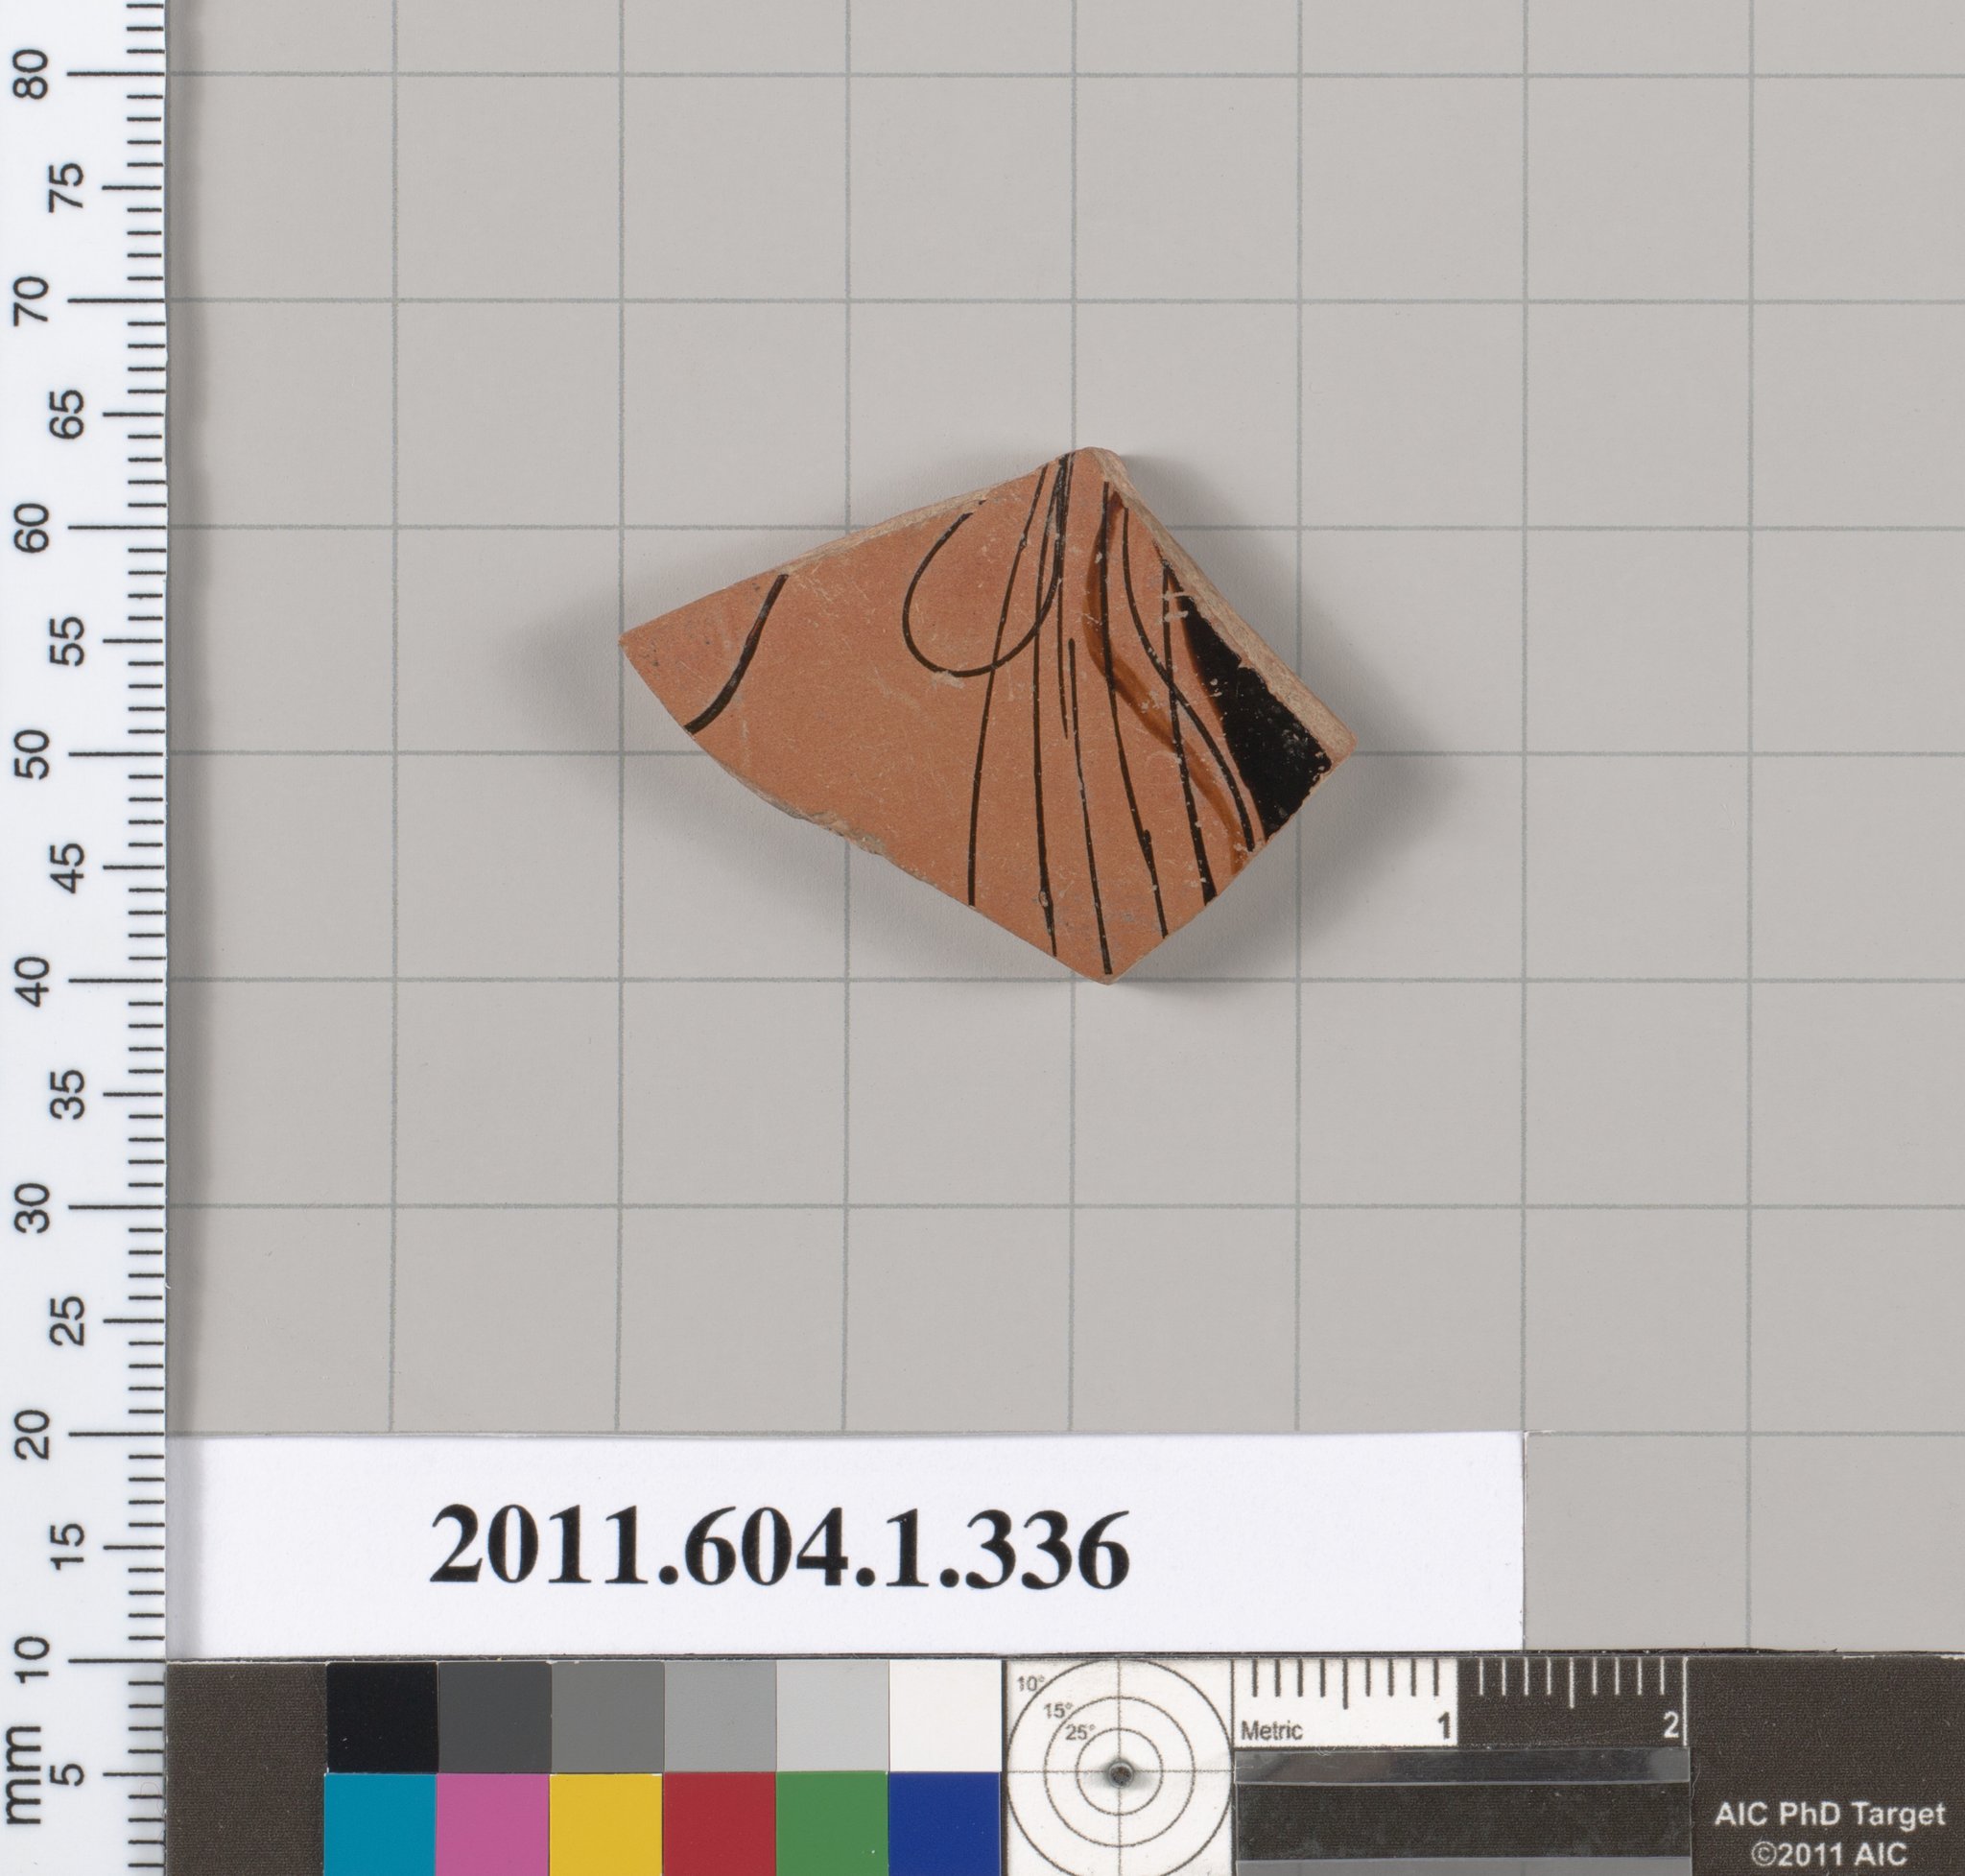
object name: kylix fragment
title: Terracotta fragment of a kylix (drinking cup)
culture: greek, attic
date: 475-451 BCE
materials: terracotta